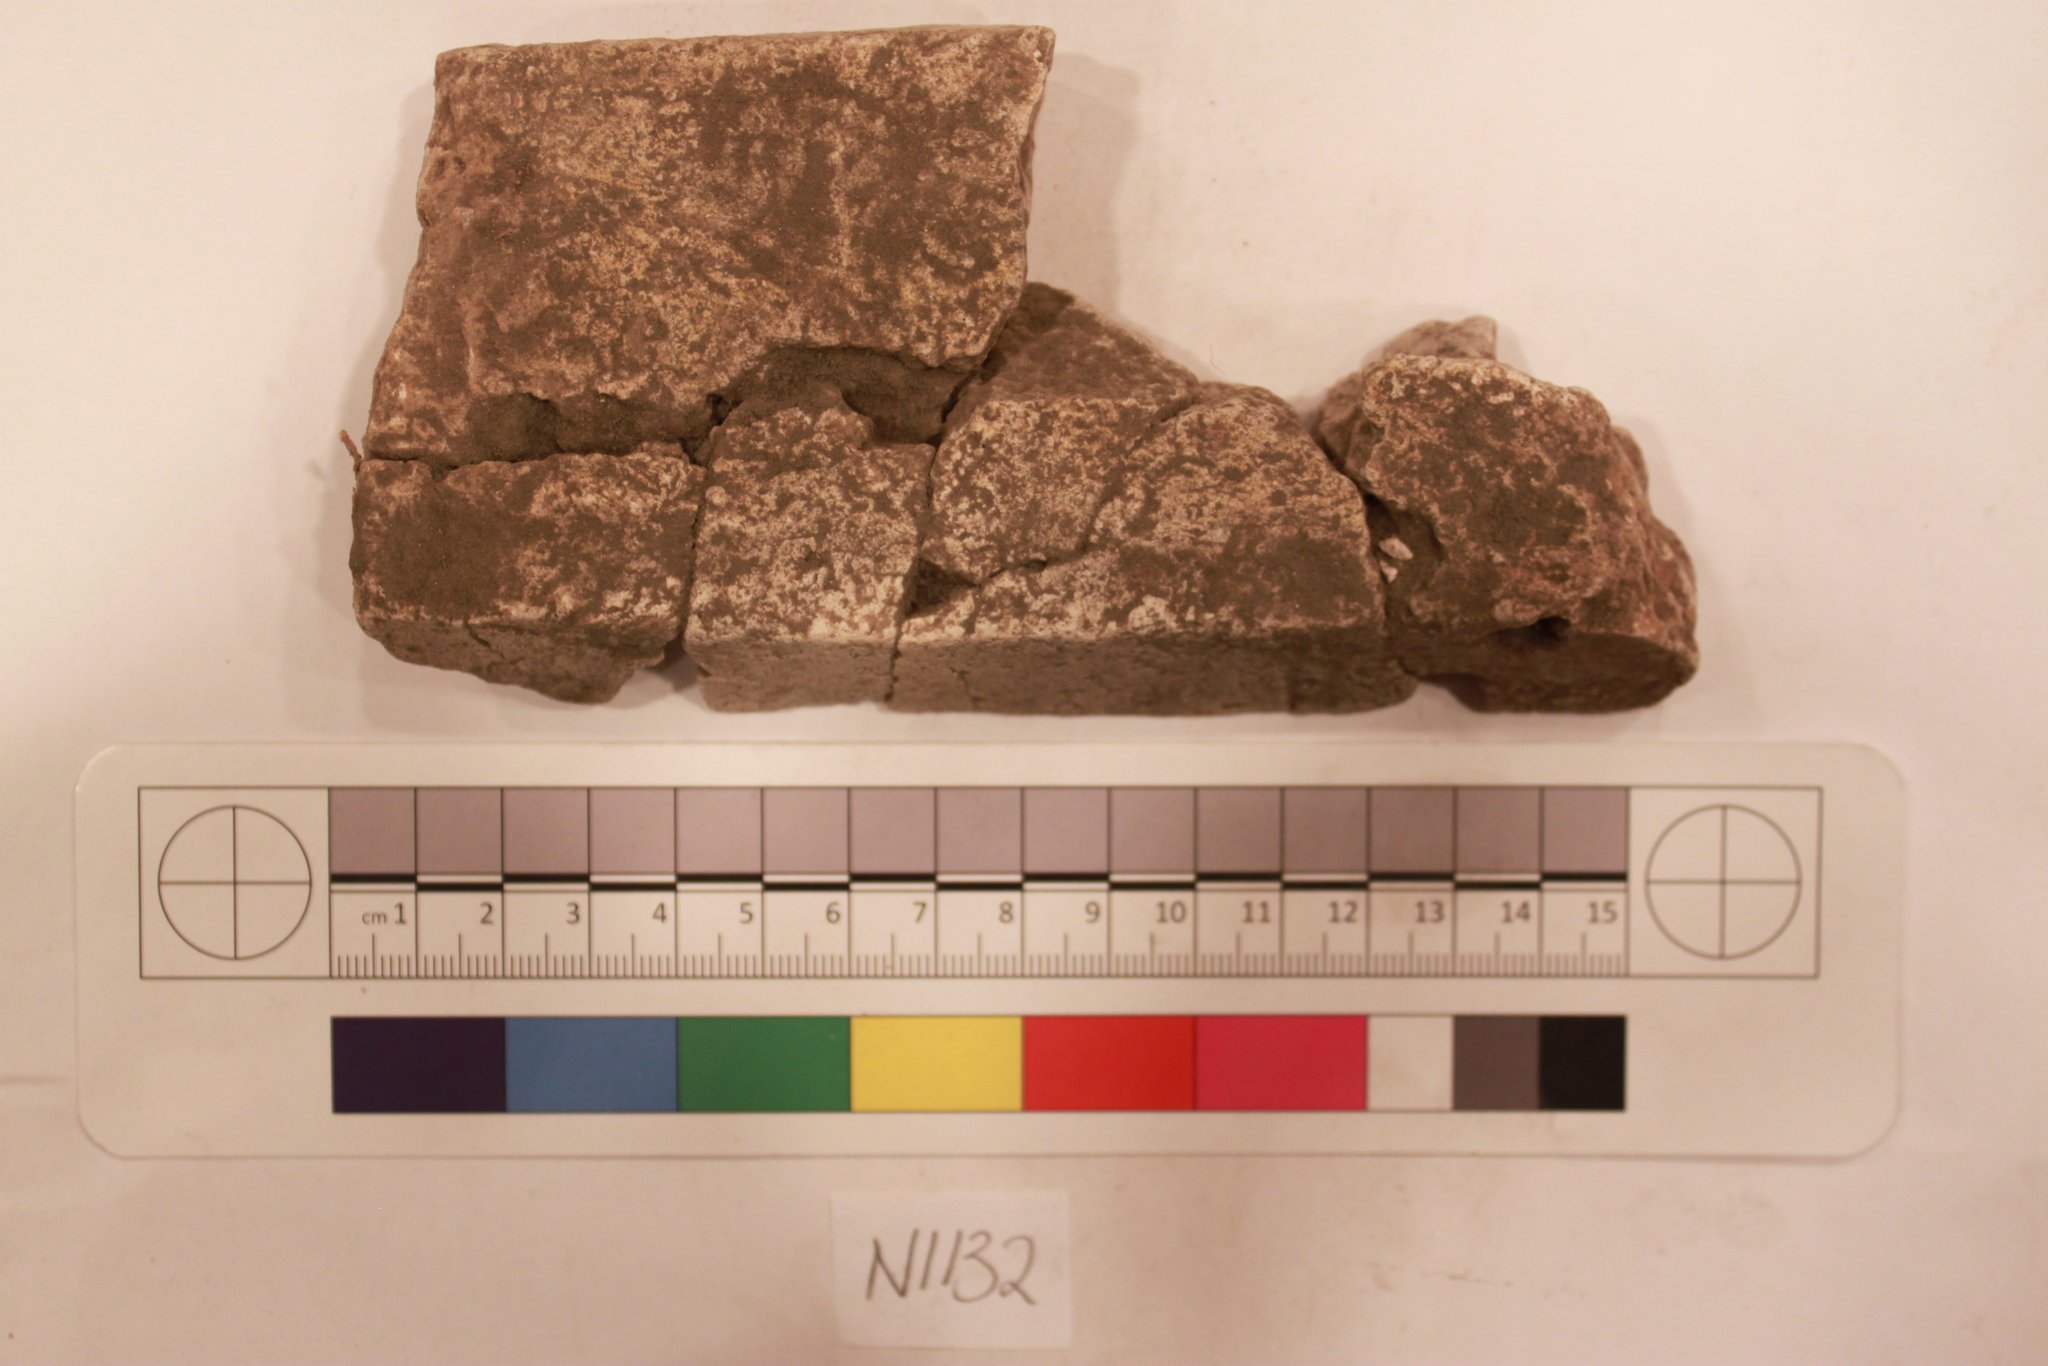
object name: fragment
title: Stucco Fragment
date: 701-1200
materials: plaster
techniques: carving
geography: iran